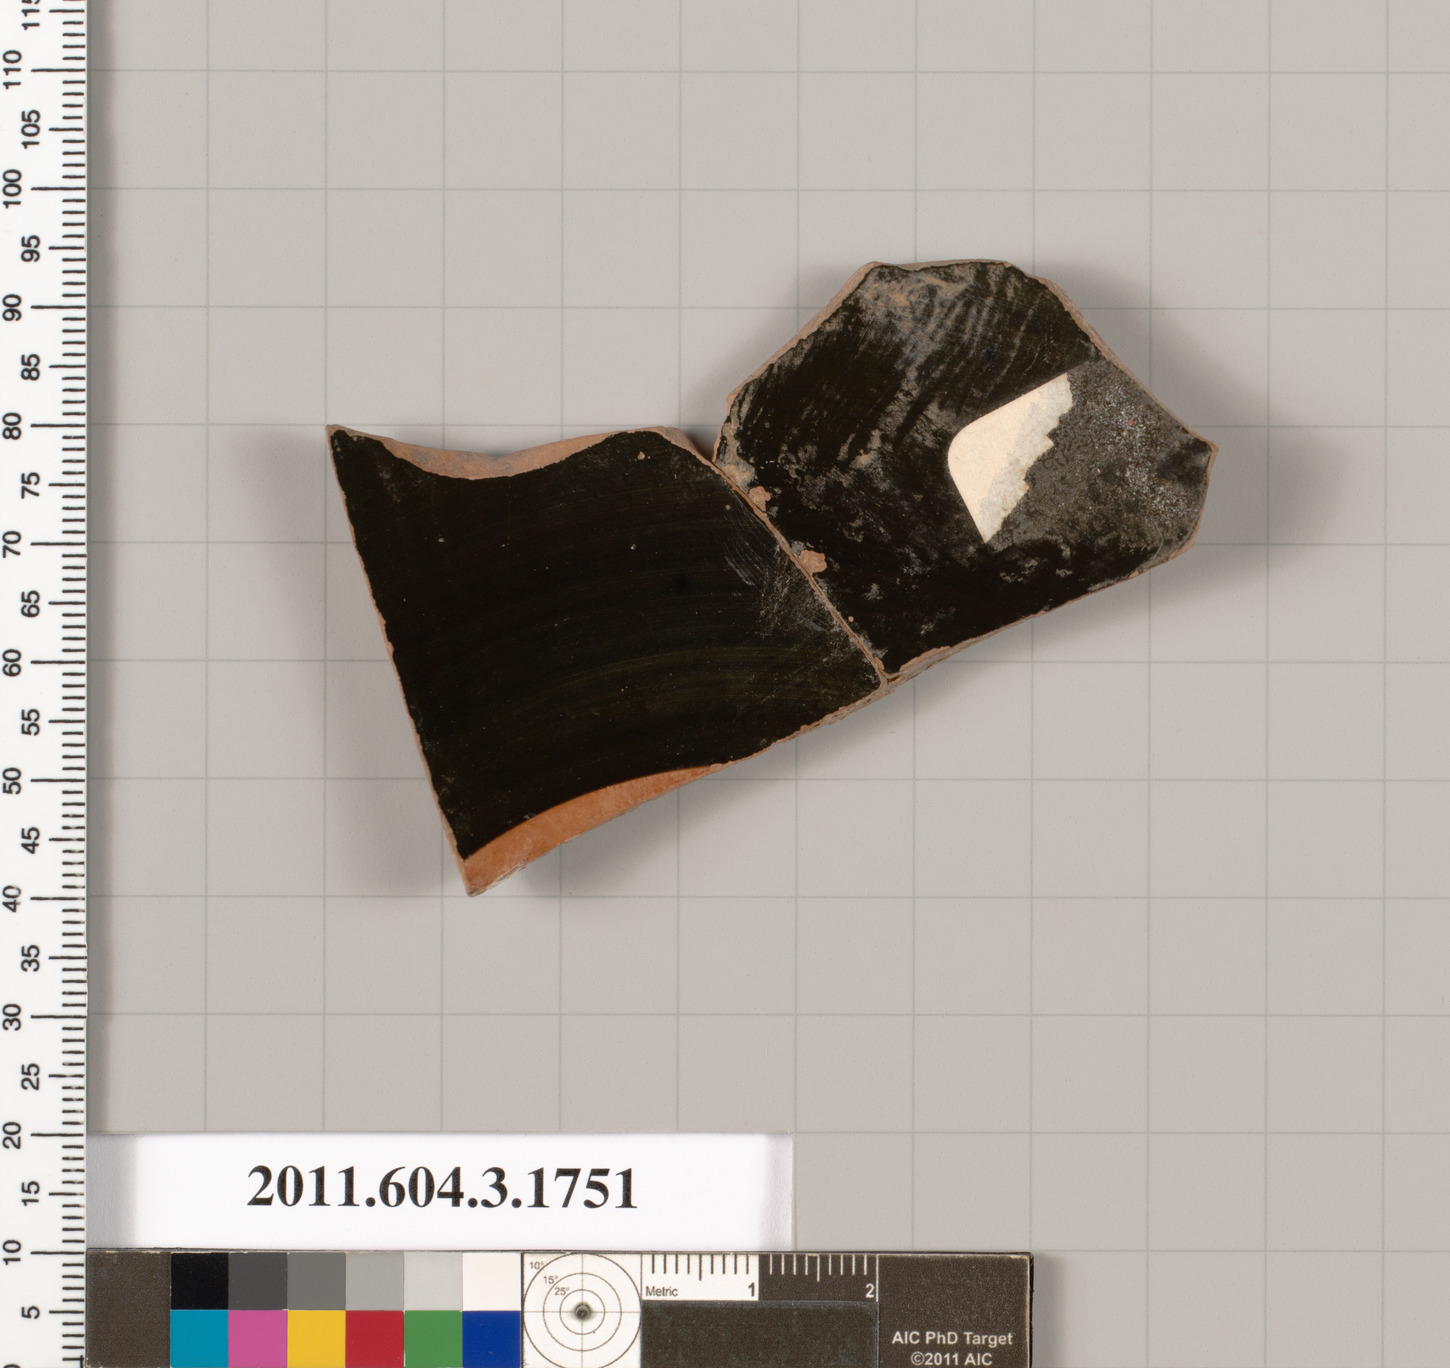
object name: kylix fragment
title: Terracotta fragment of a kylix: Band or lip cup (drinking cup)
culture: greek, attic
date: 550-526 BCE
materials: terracotta